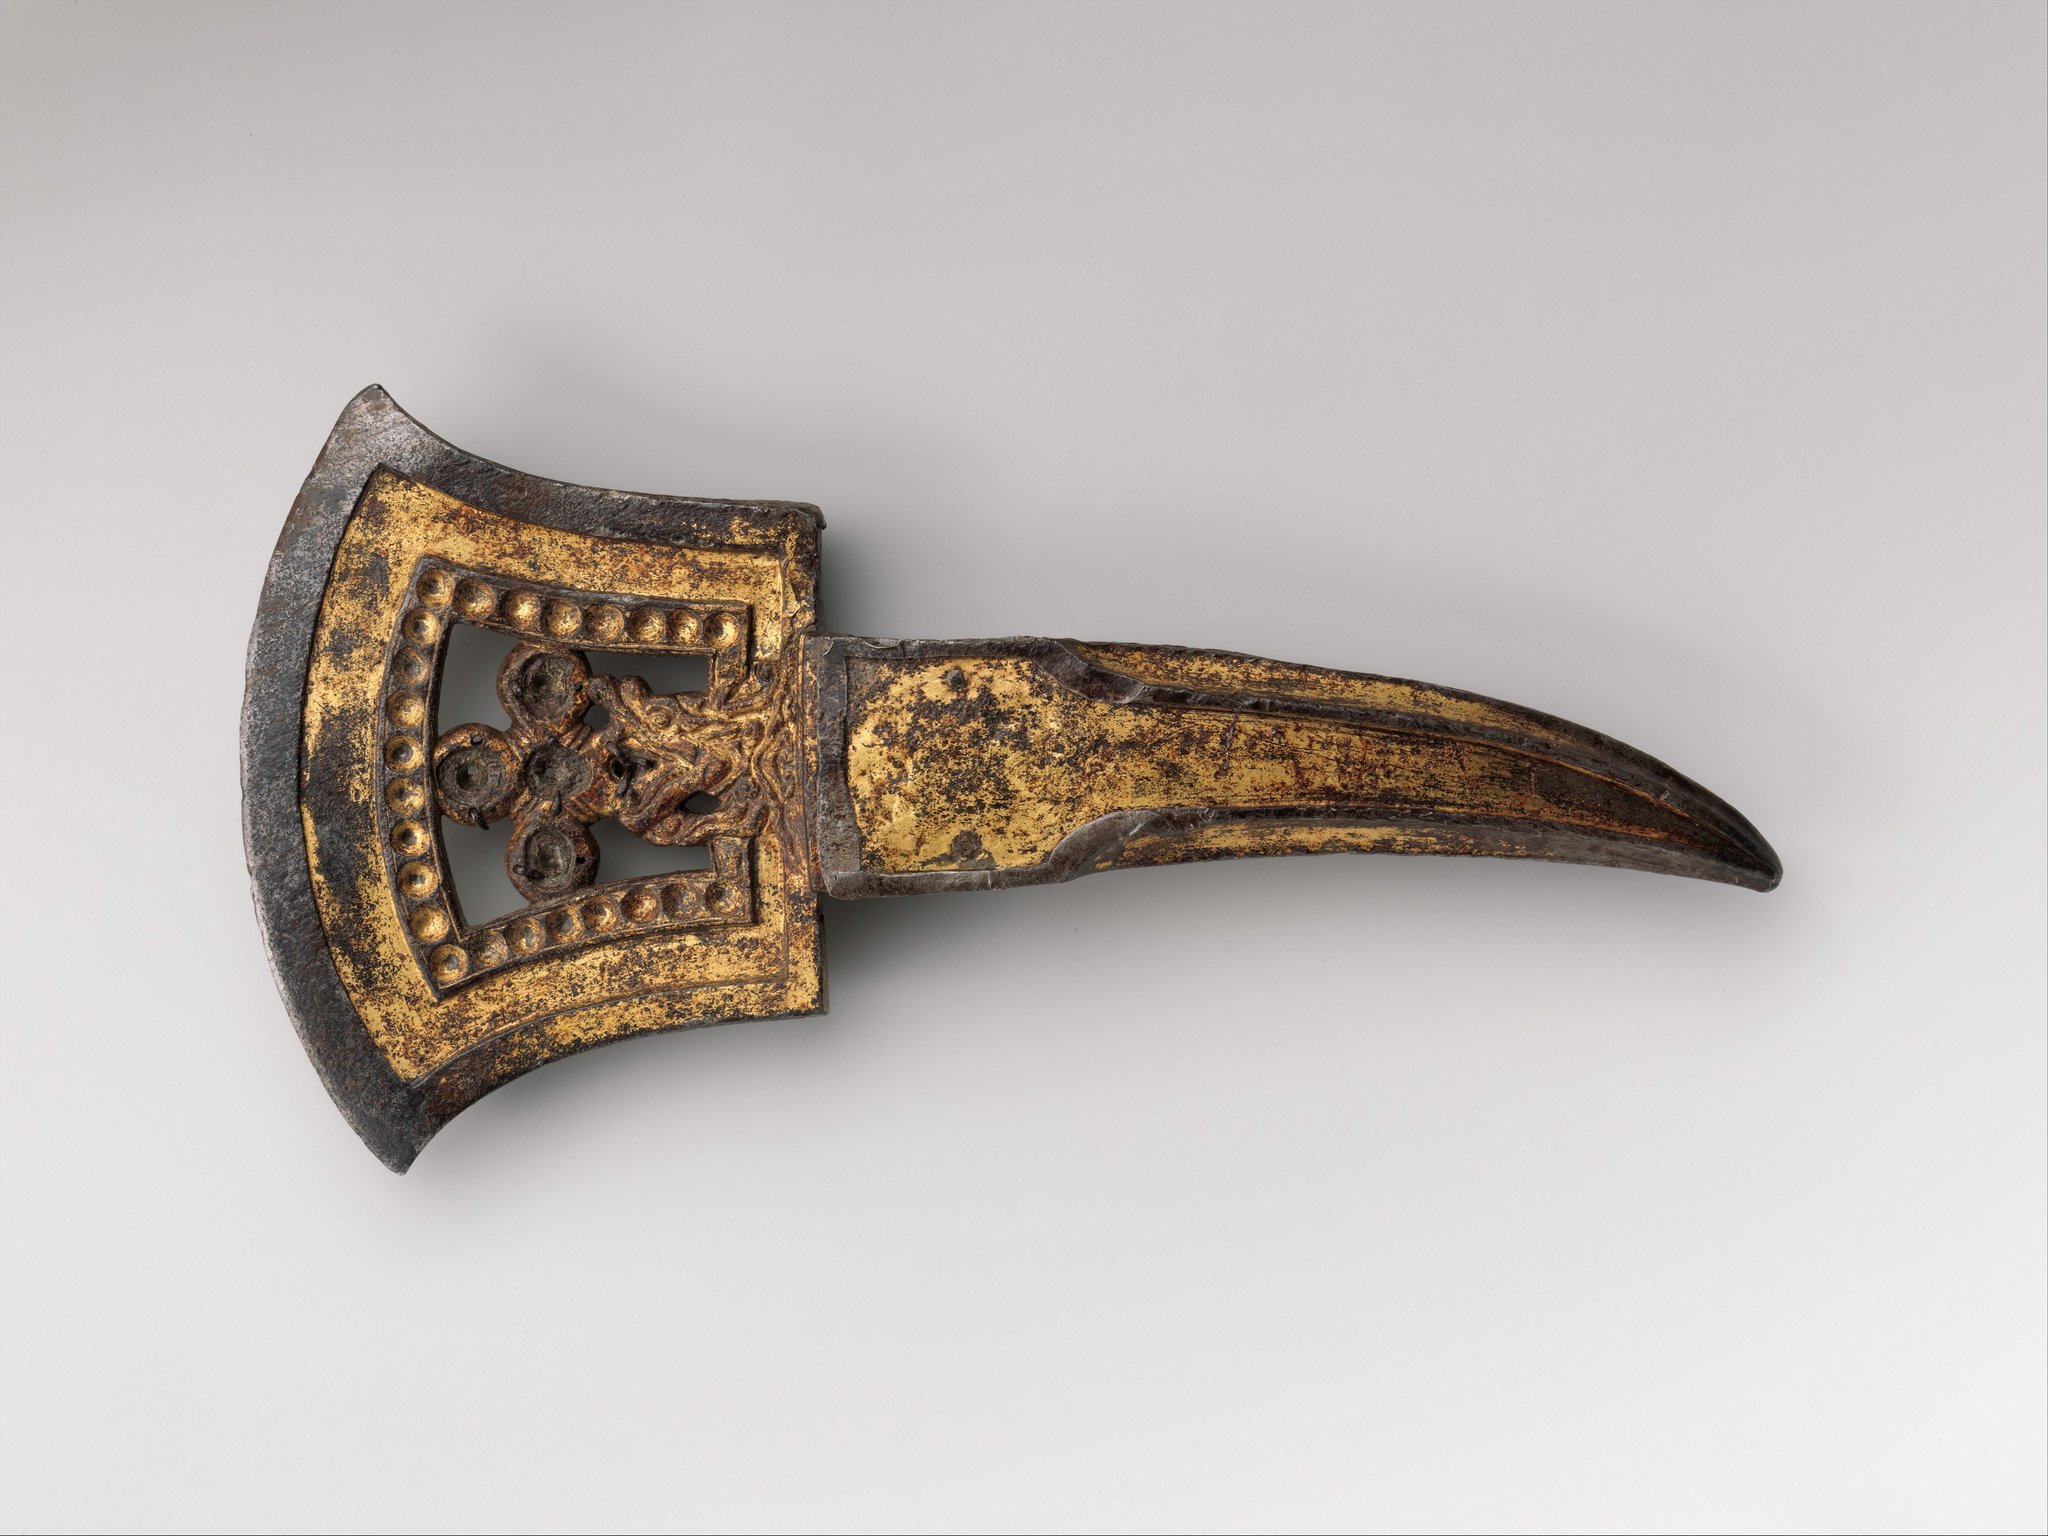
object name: ax head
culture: mongolian or tibetan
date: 1201-1600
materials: gold, iron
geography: tibet